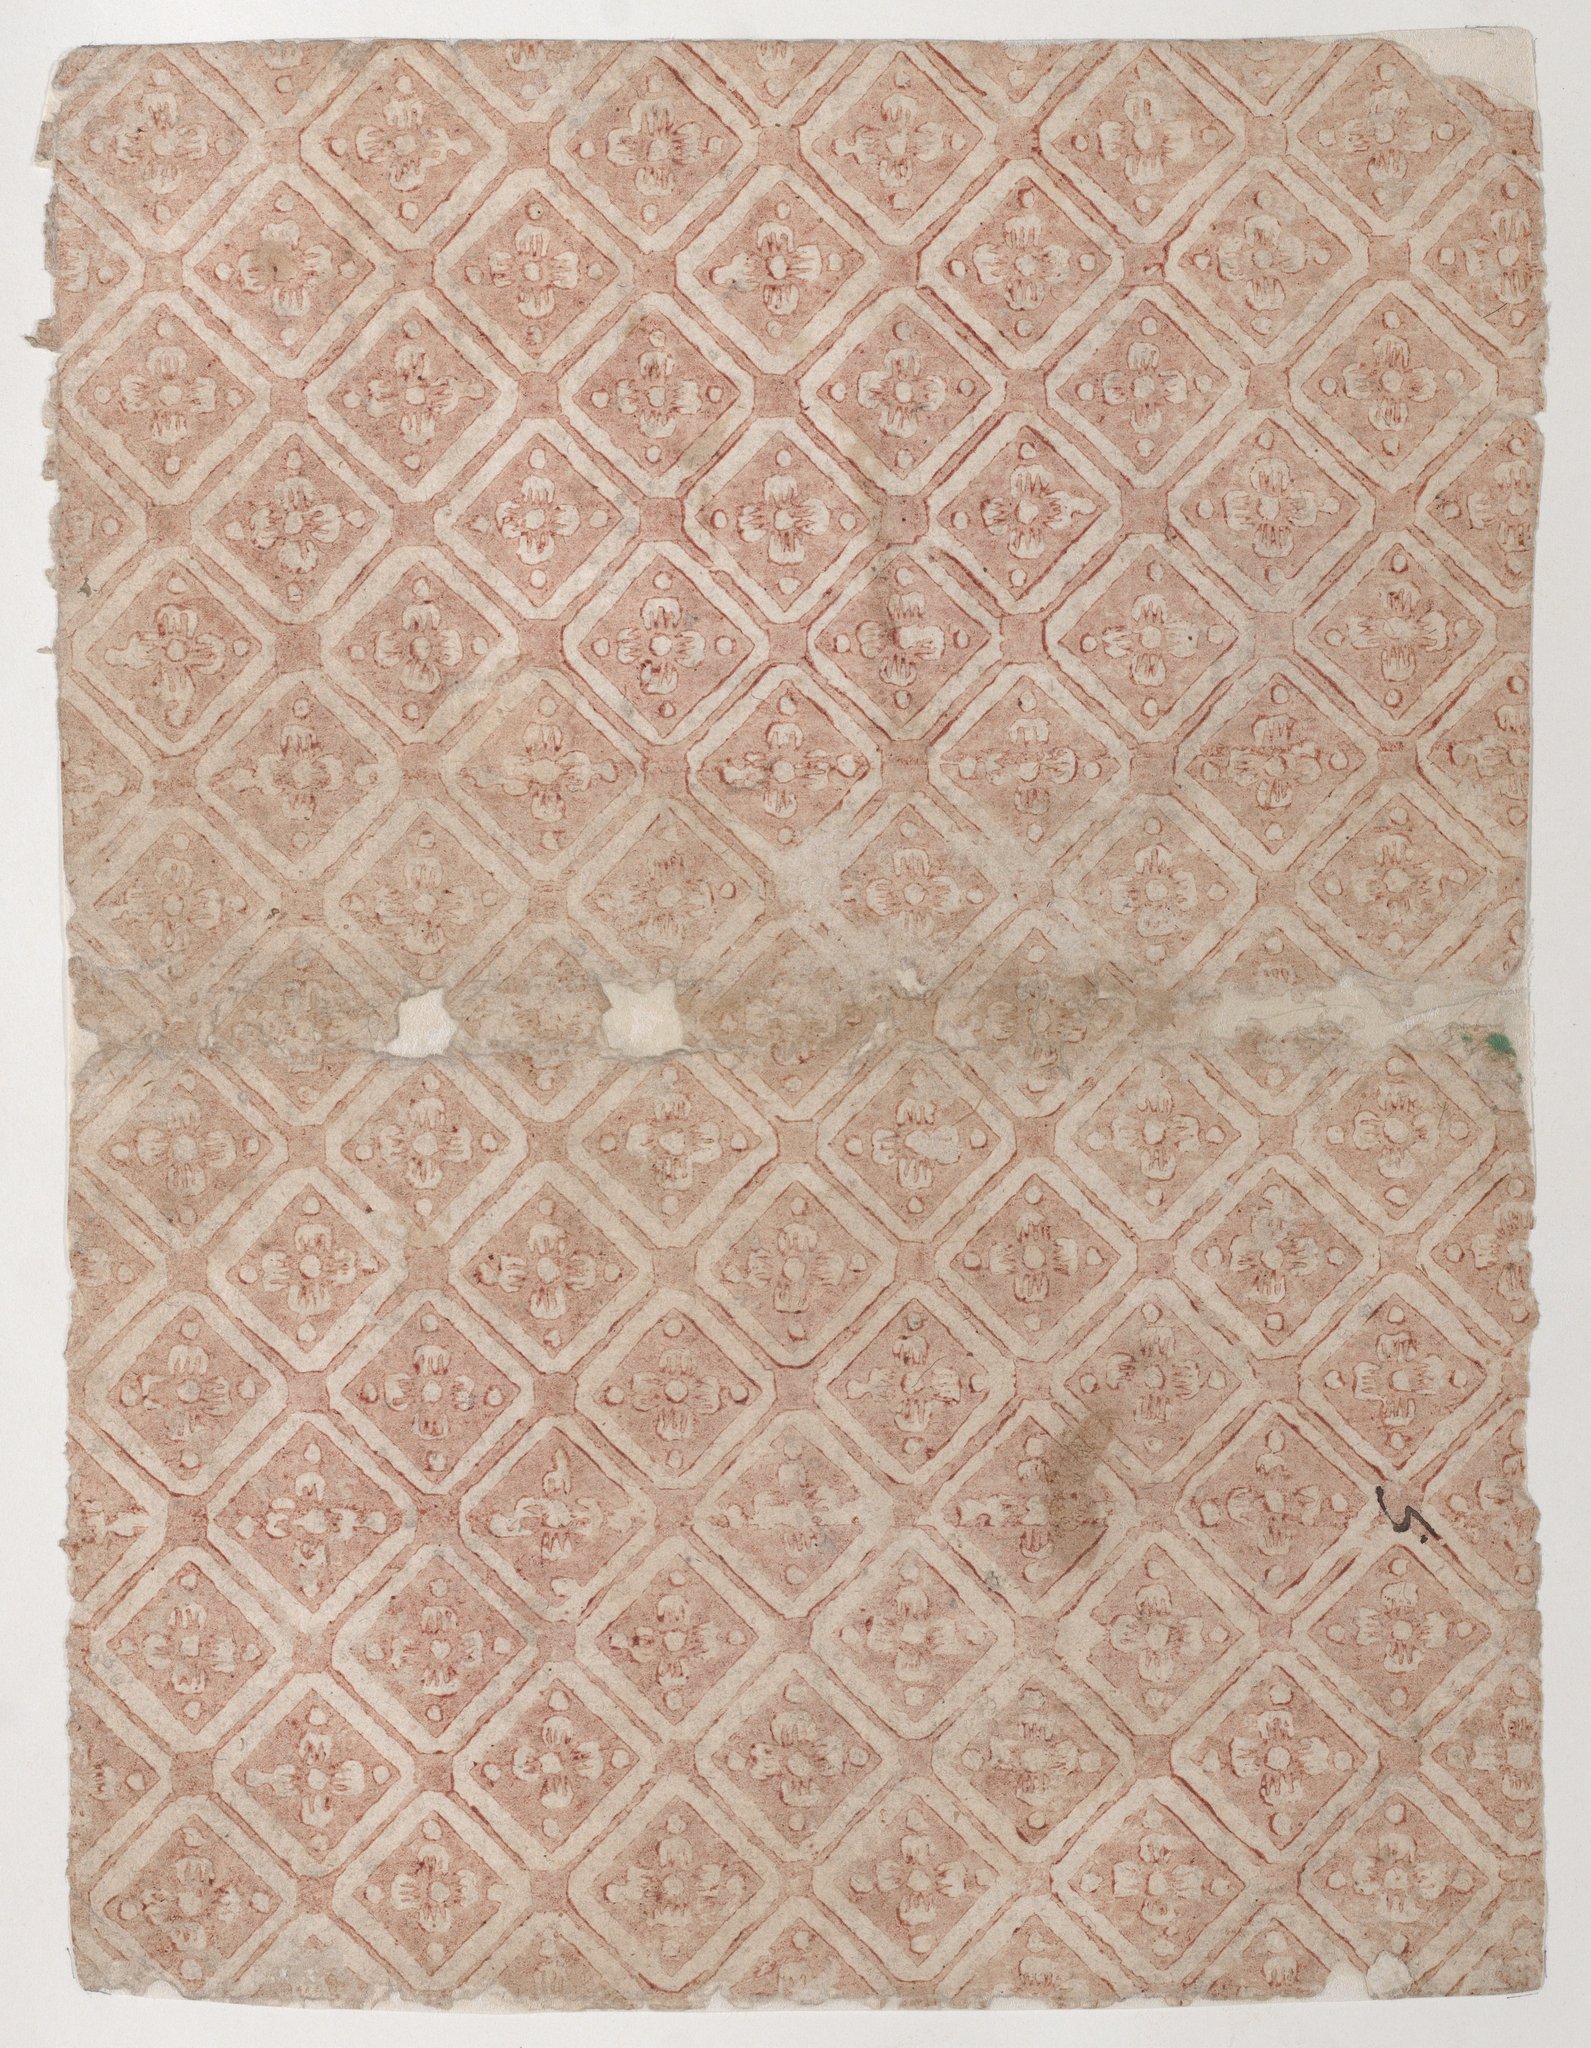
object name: print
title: Book cover with overall pattern of diamonds with rosettes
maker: Anonymous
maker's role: artist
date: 1801-1900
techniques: relief print